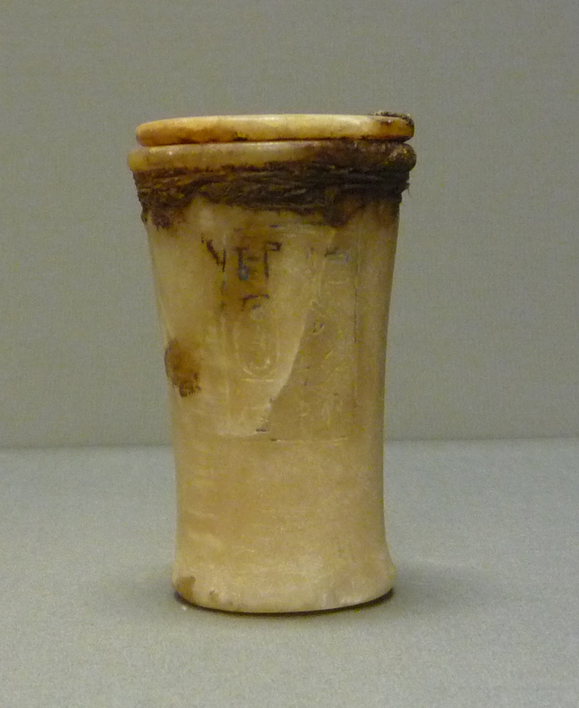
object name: ointment jar, foundation deposit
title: Ointment Jar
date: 1479-1458 BCE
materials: stone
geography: egypt